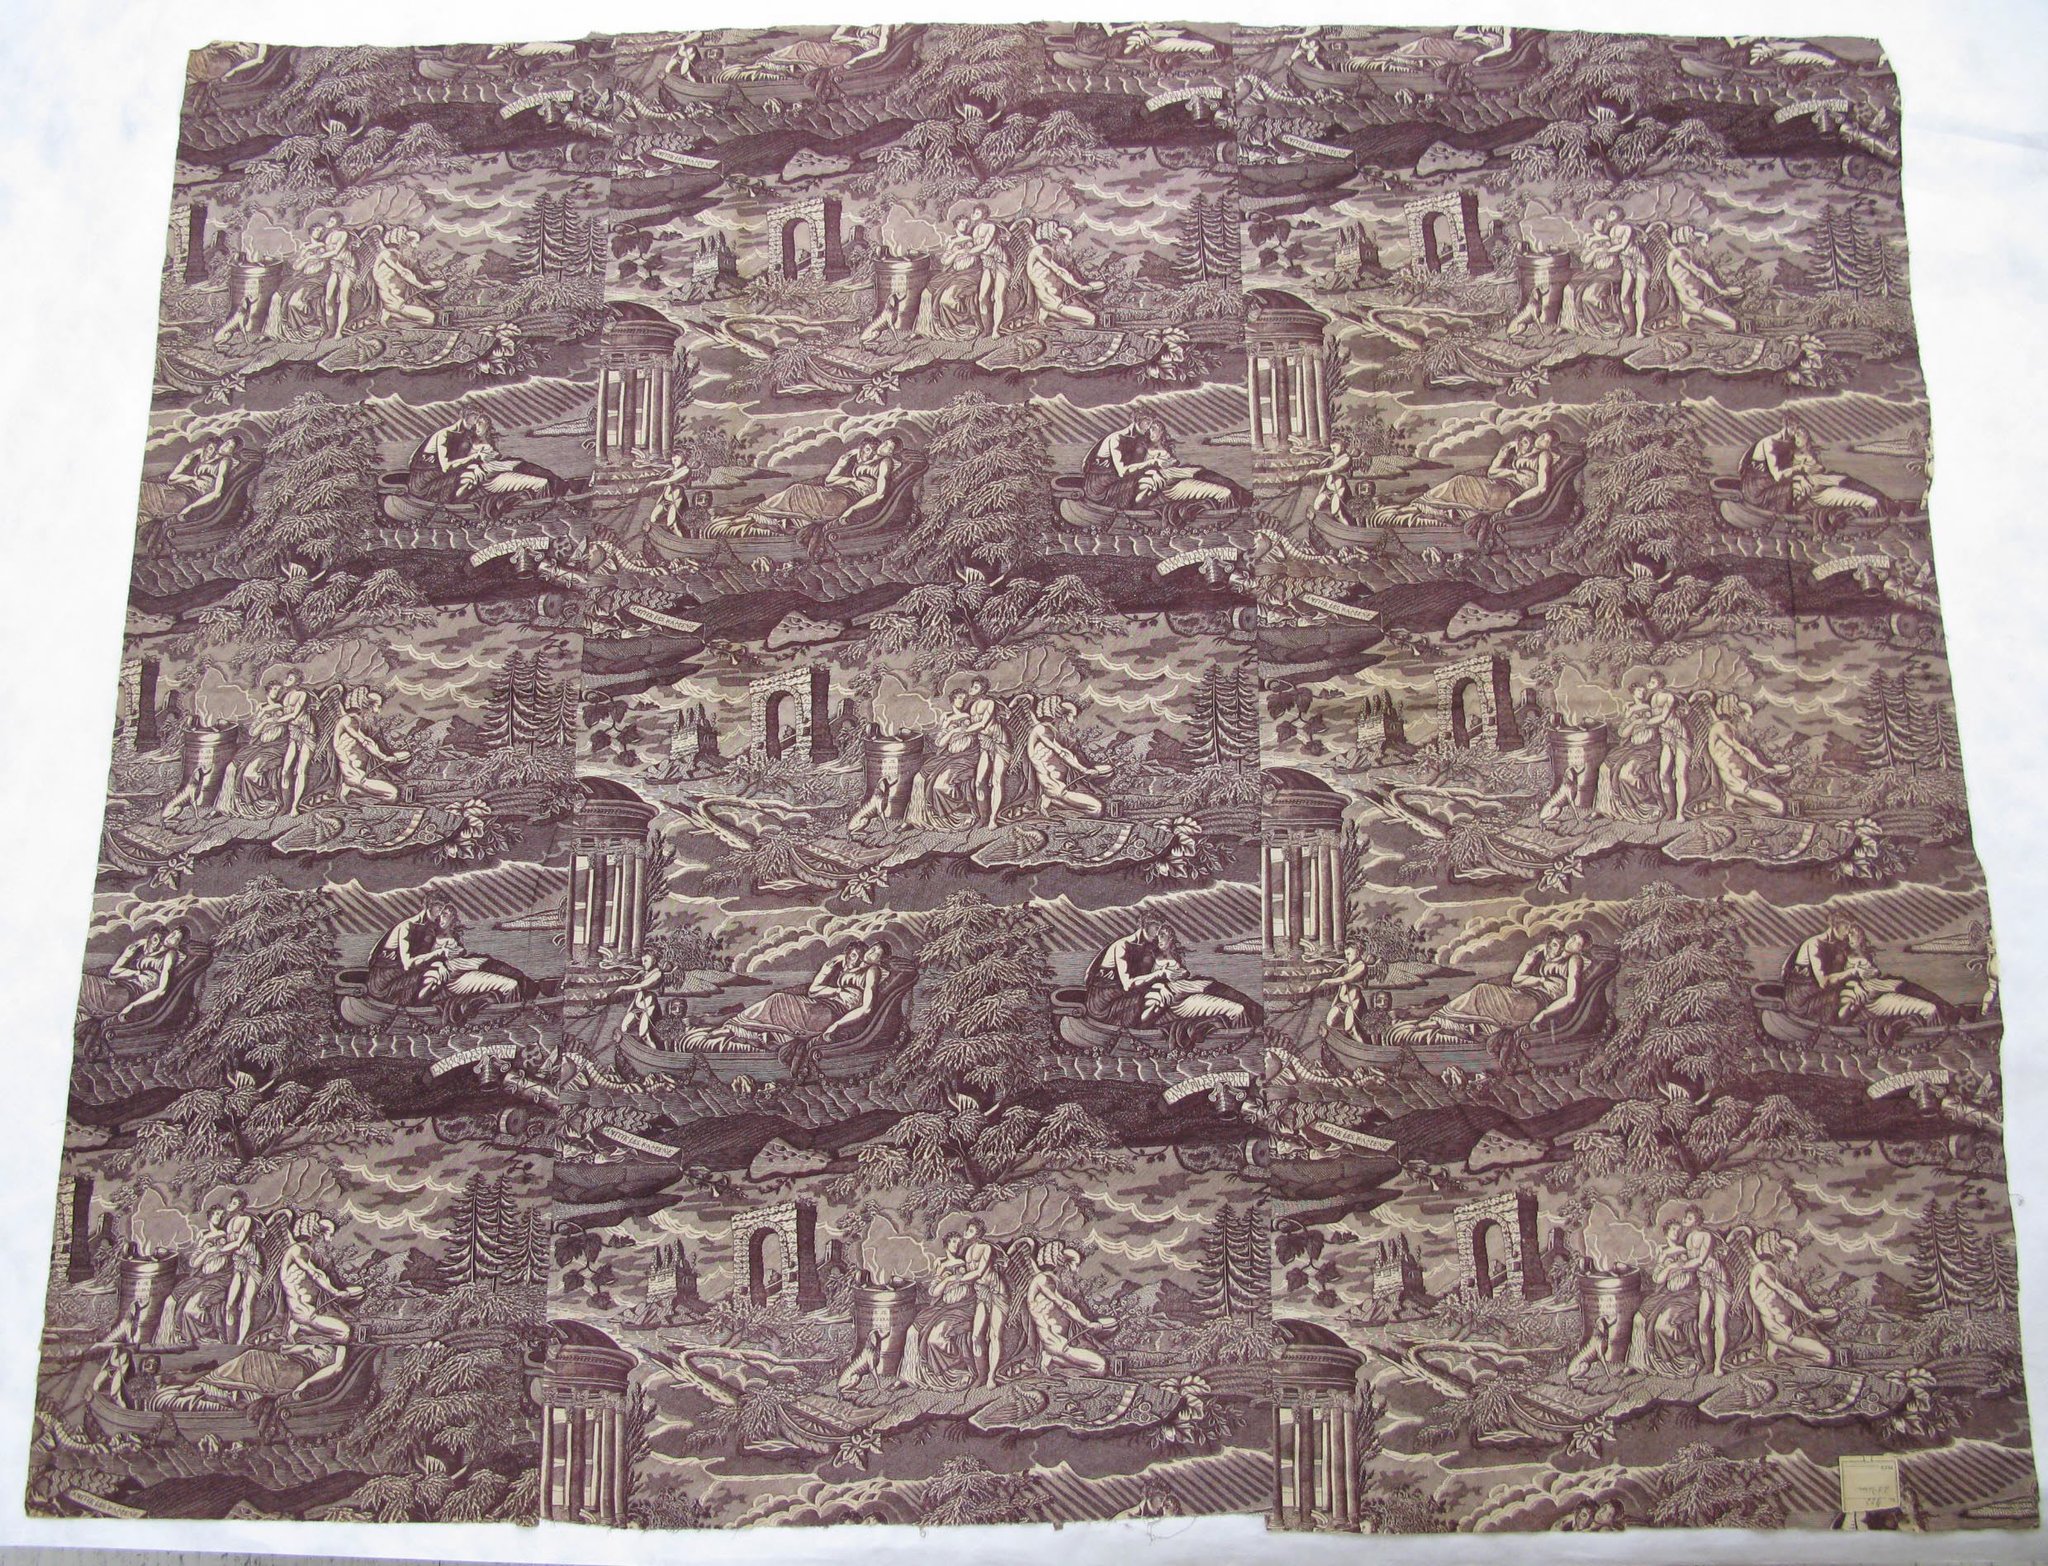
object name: length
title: The Lovers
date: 1826-1850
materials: cotton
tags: men,women,dogs